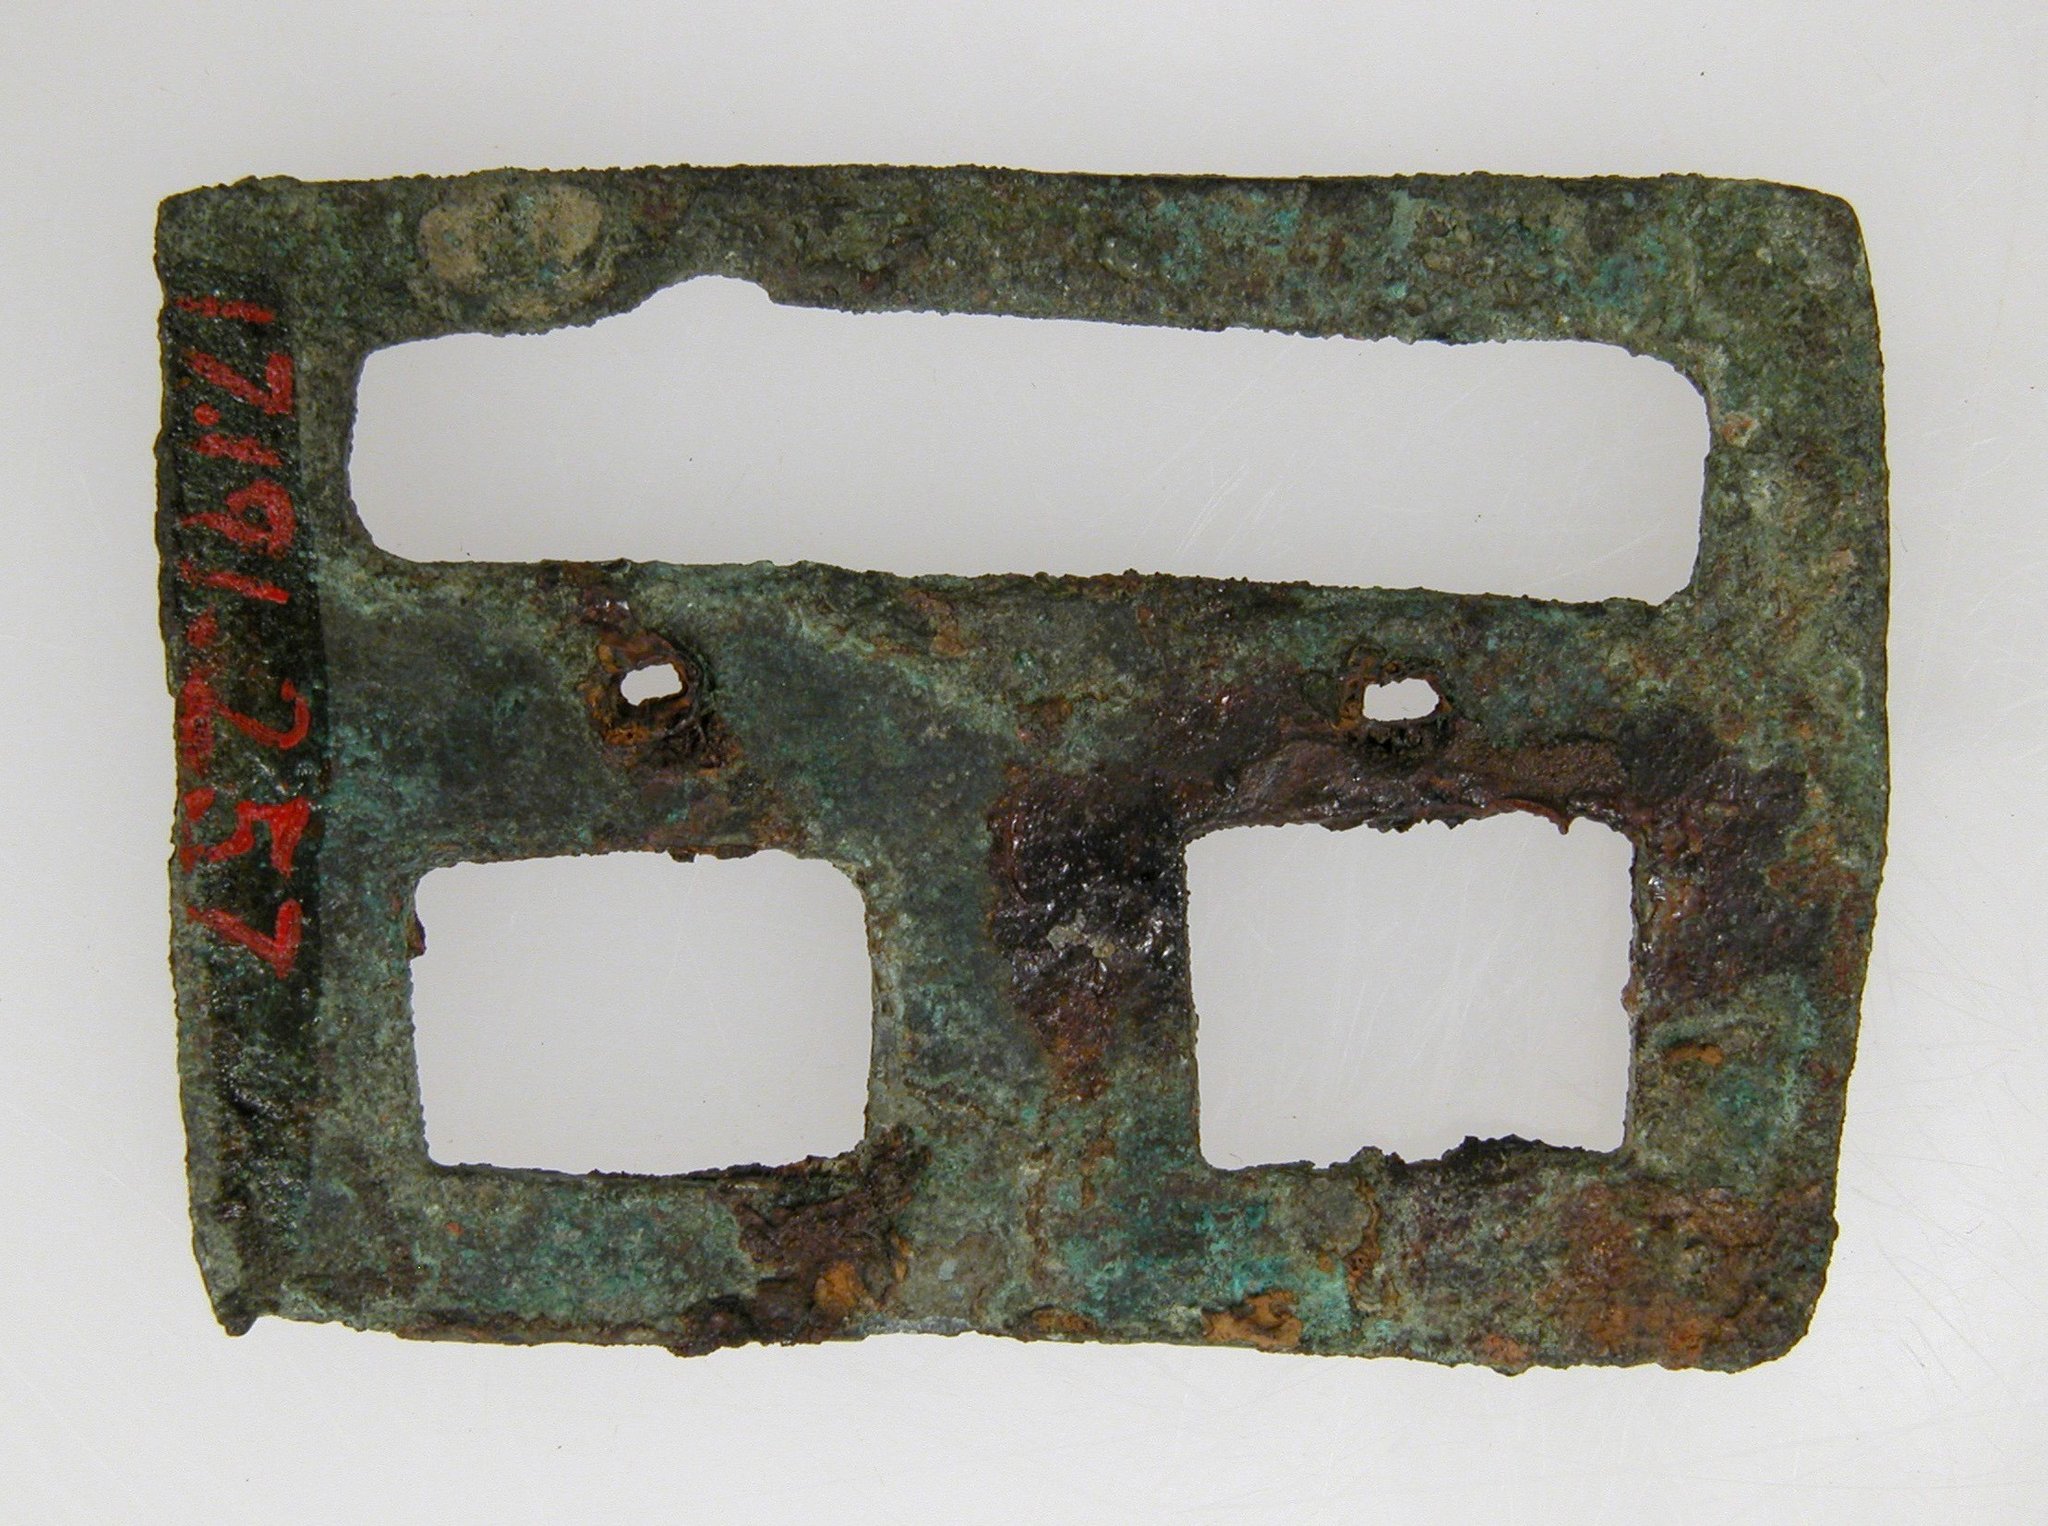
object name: plaque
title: Flat Rectangular Plaque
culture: frankish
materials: copper alloy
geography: northern france